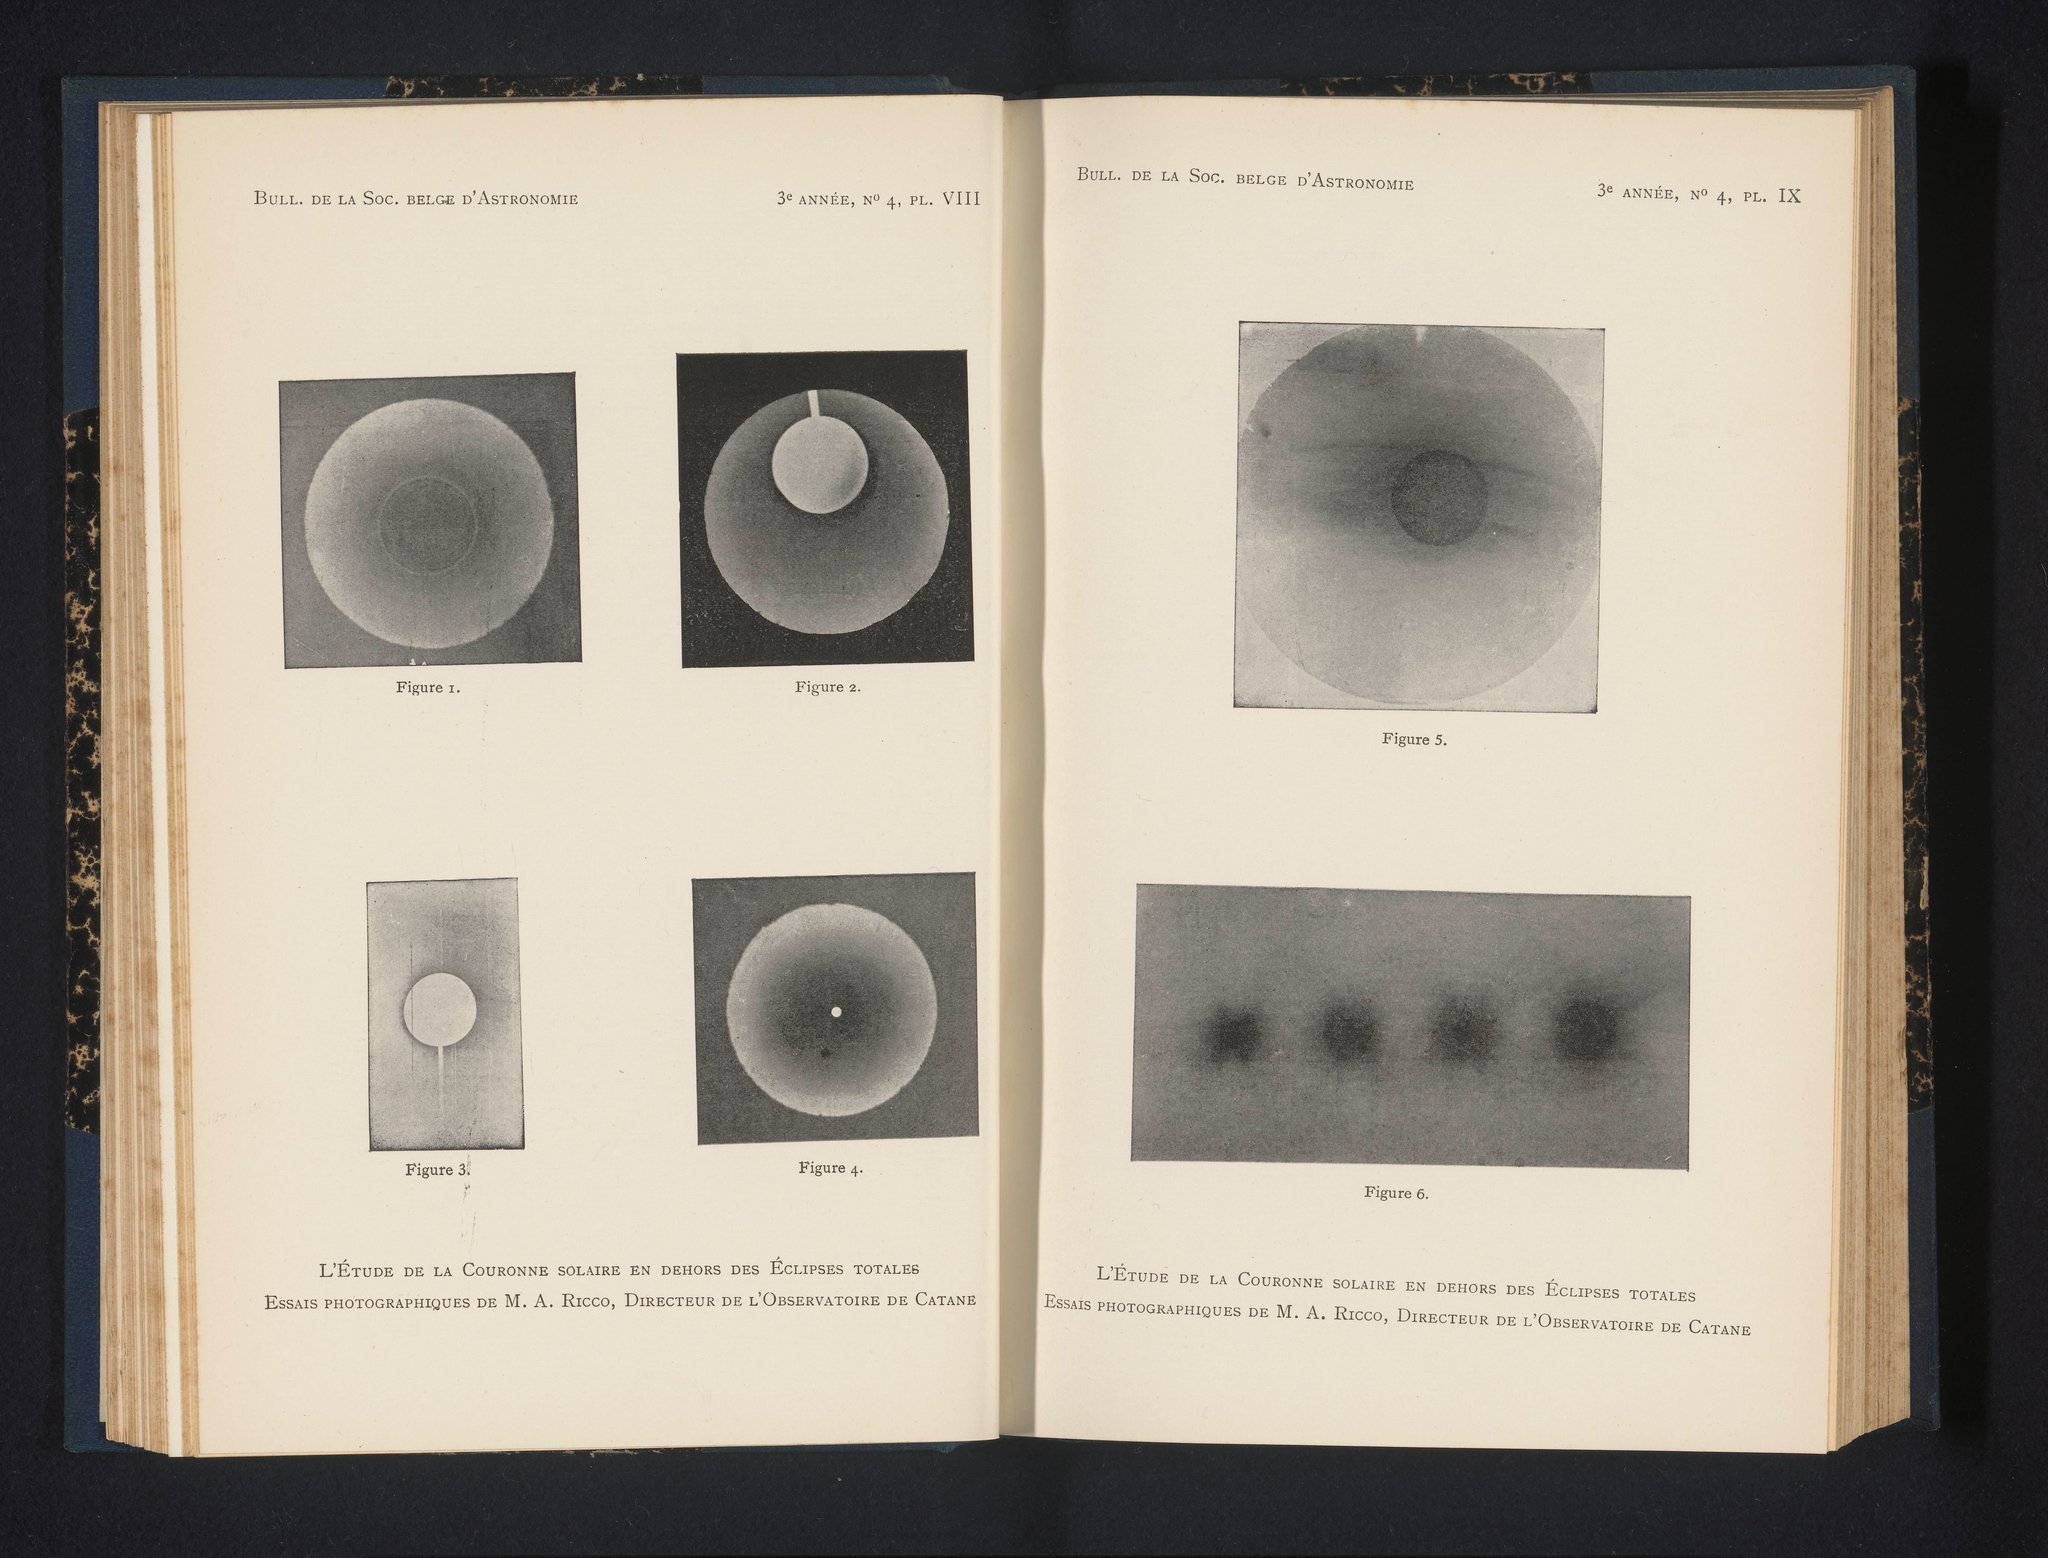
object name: page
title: L'Étude de la couronne solaire en dehors de éclipses totales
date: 1893-1898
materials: paper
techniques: autotype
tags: sun as celestial body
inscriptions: inscription: ‘3e Année, no 4, PL VIII/ Essais photographiques de M. A. Ricco, Directeur de l'Observatoire de Catane’